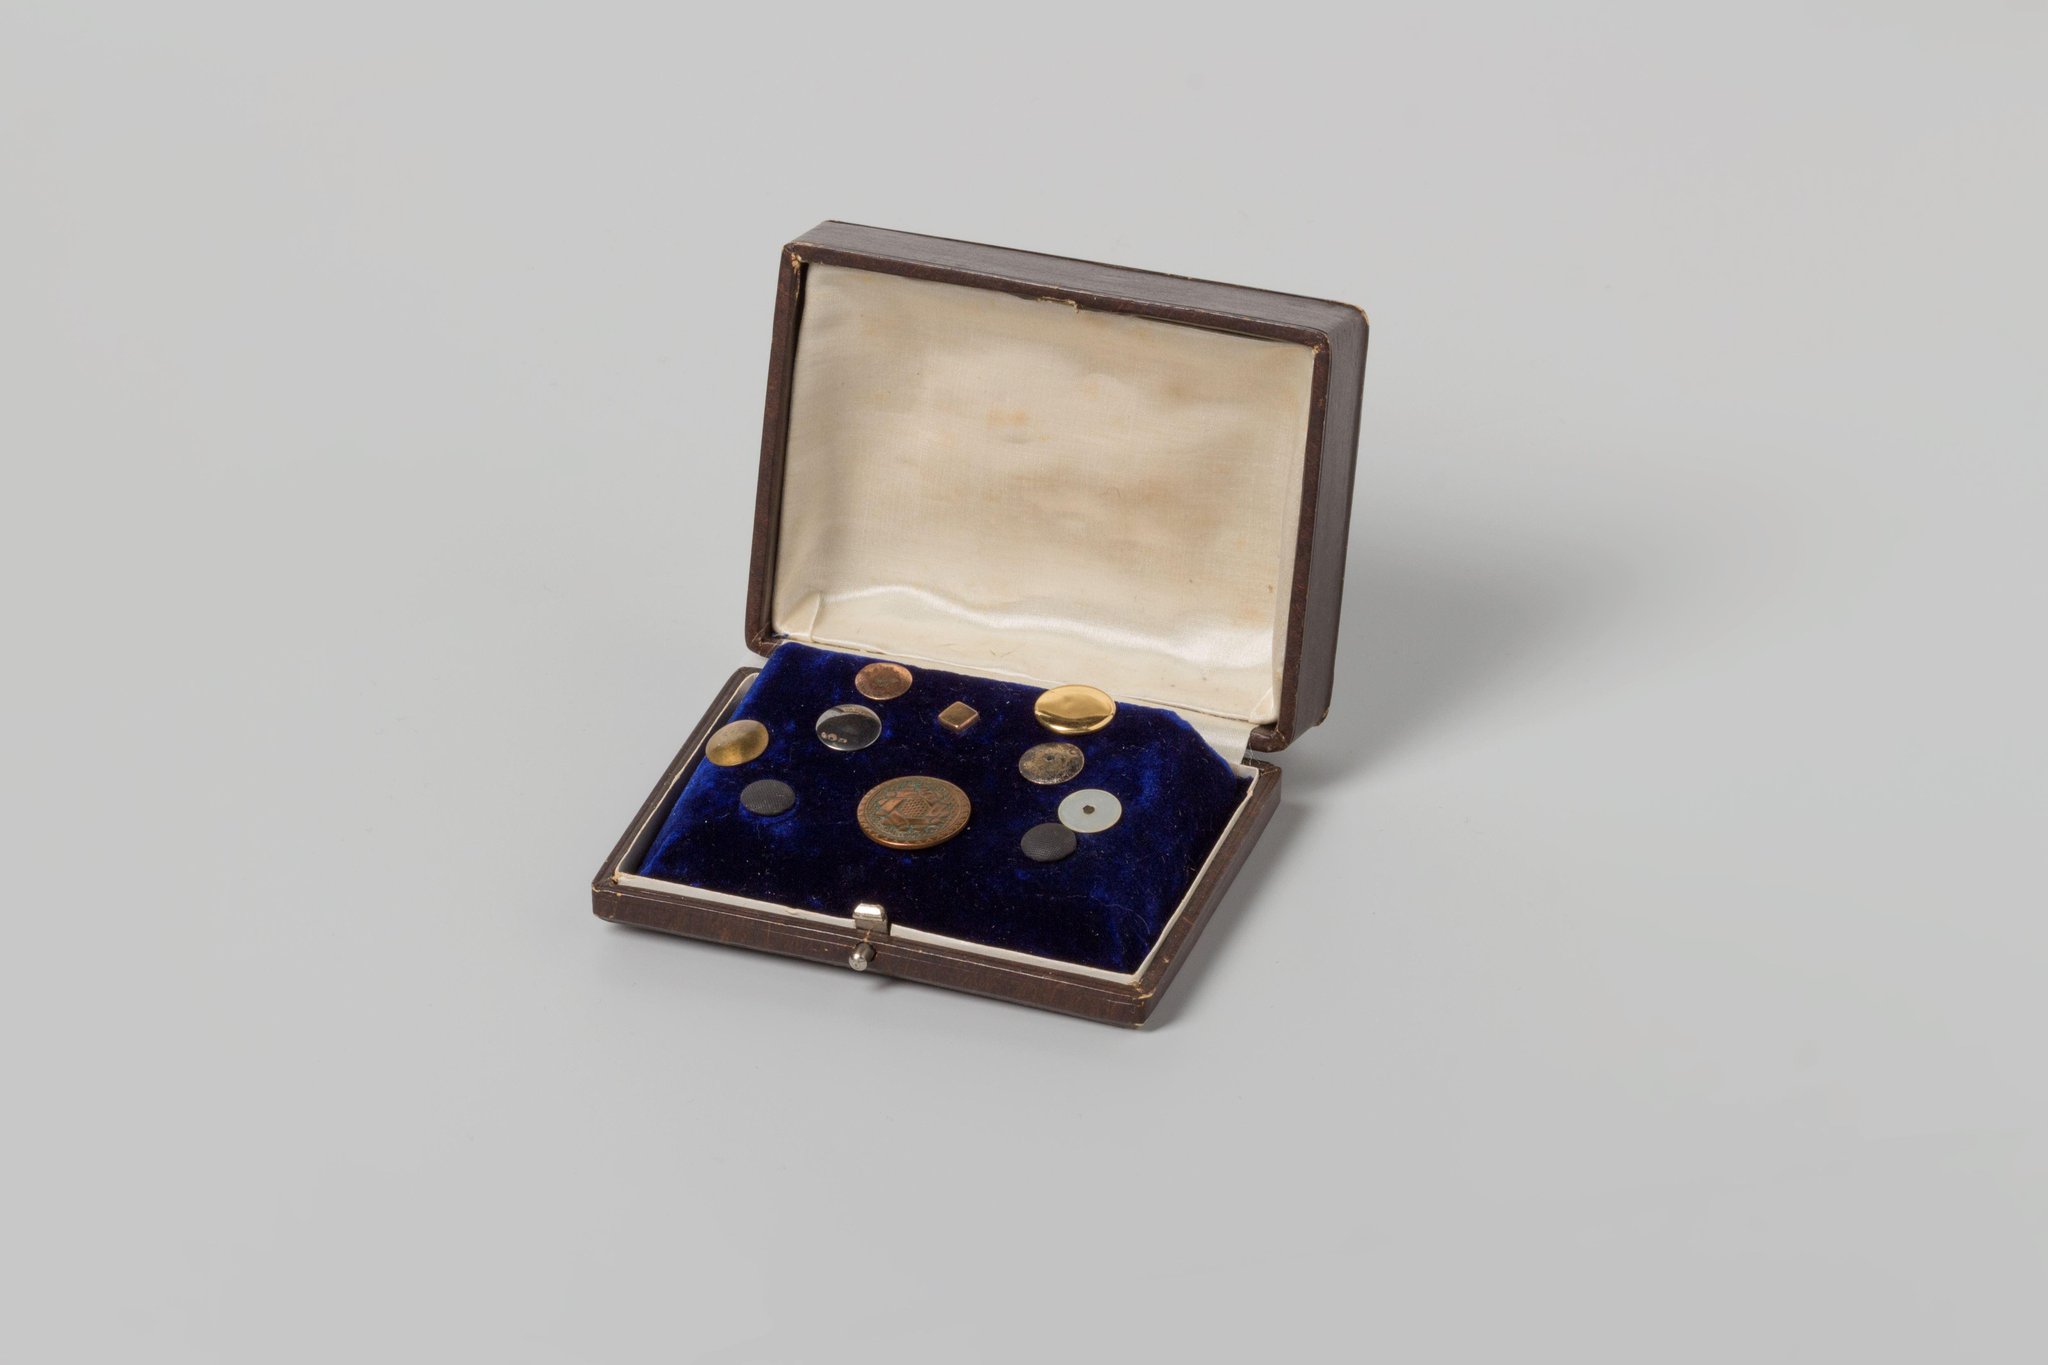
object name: menswear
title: Vierkante vestknoop of boordeknoop van koper en zwart kunststof; voor de rouw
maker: Anonymous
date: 1900-1925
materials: copper, plastic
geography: western europe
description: Vierkante vestknoop of boordeknoop van koper en zwart kunststof. Voor de rouw.